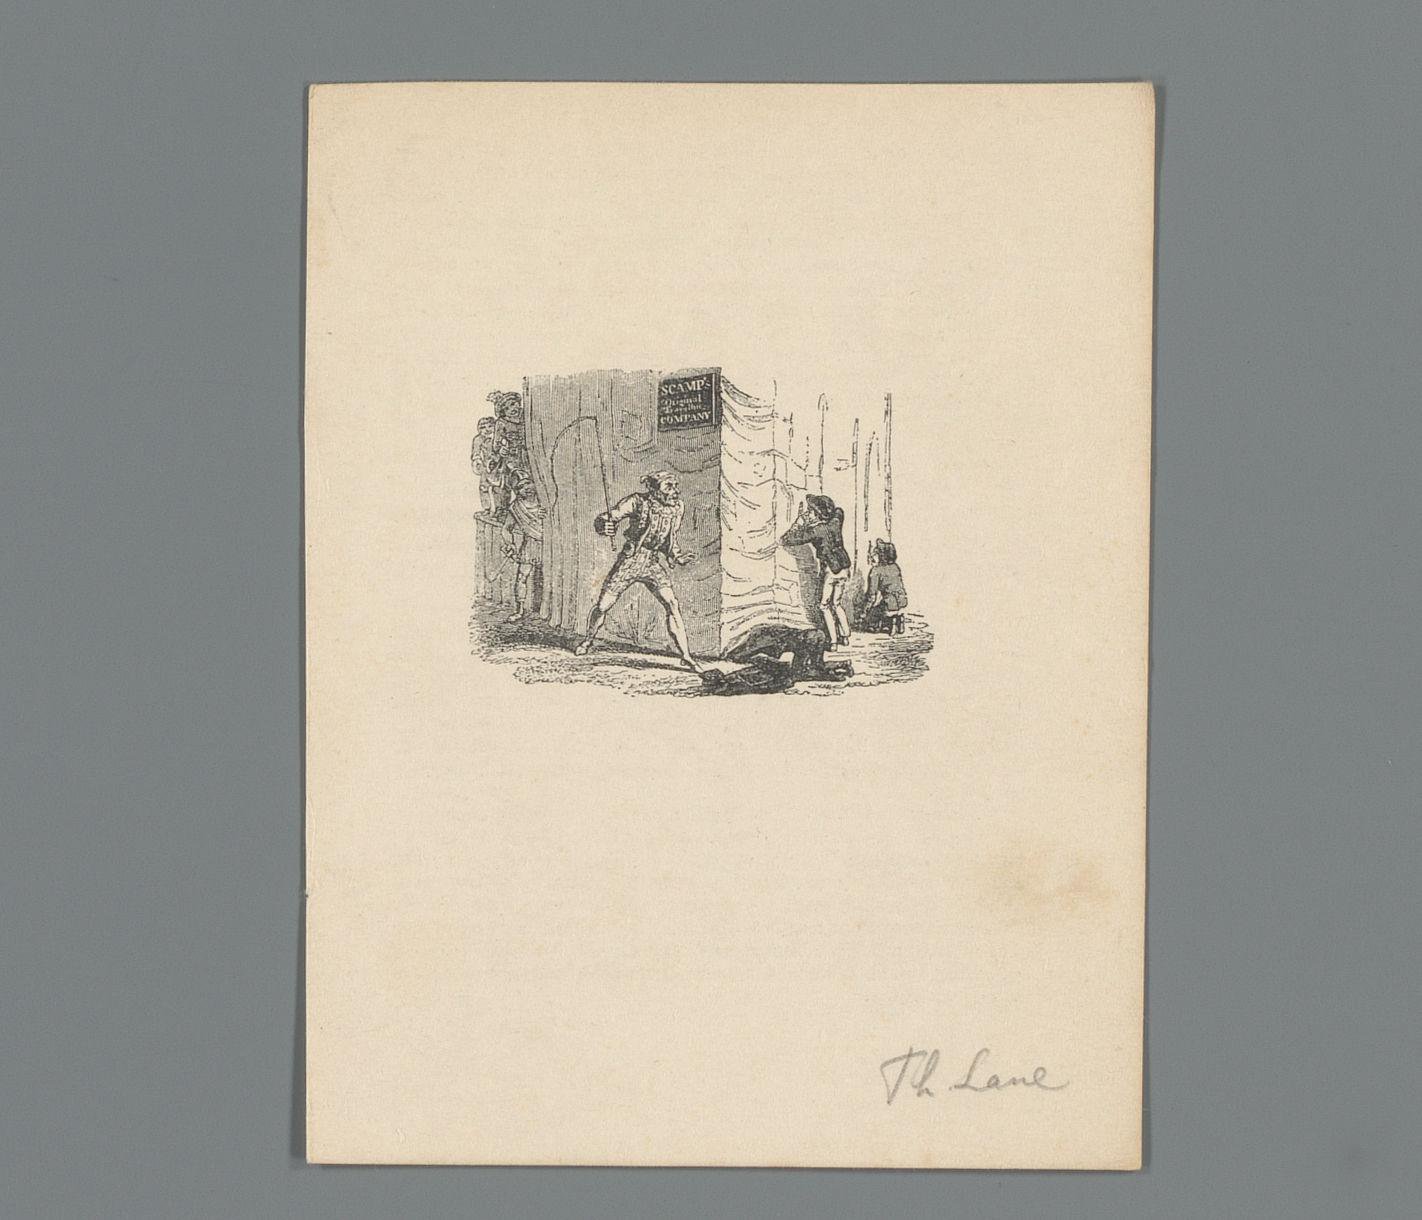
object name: print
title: Jongens gluren door het toneeldoek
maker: theodore lane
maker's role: draughtsman, painter, print maker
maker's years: 1800-1828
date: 1823-1825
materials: paper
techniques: etching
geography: england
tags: theatre, theatrical performance, the audience ~ art performance, political caricatures and satires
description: Jongens die door het tentdoek naar het toneel proberen te kijken worden weggejaagd. Onderdeel van een groep van zeven boekillustraties uit: The Life of an Actor (1825).